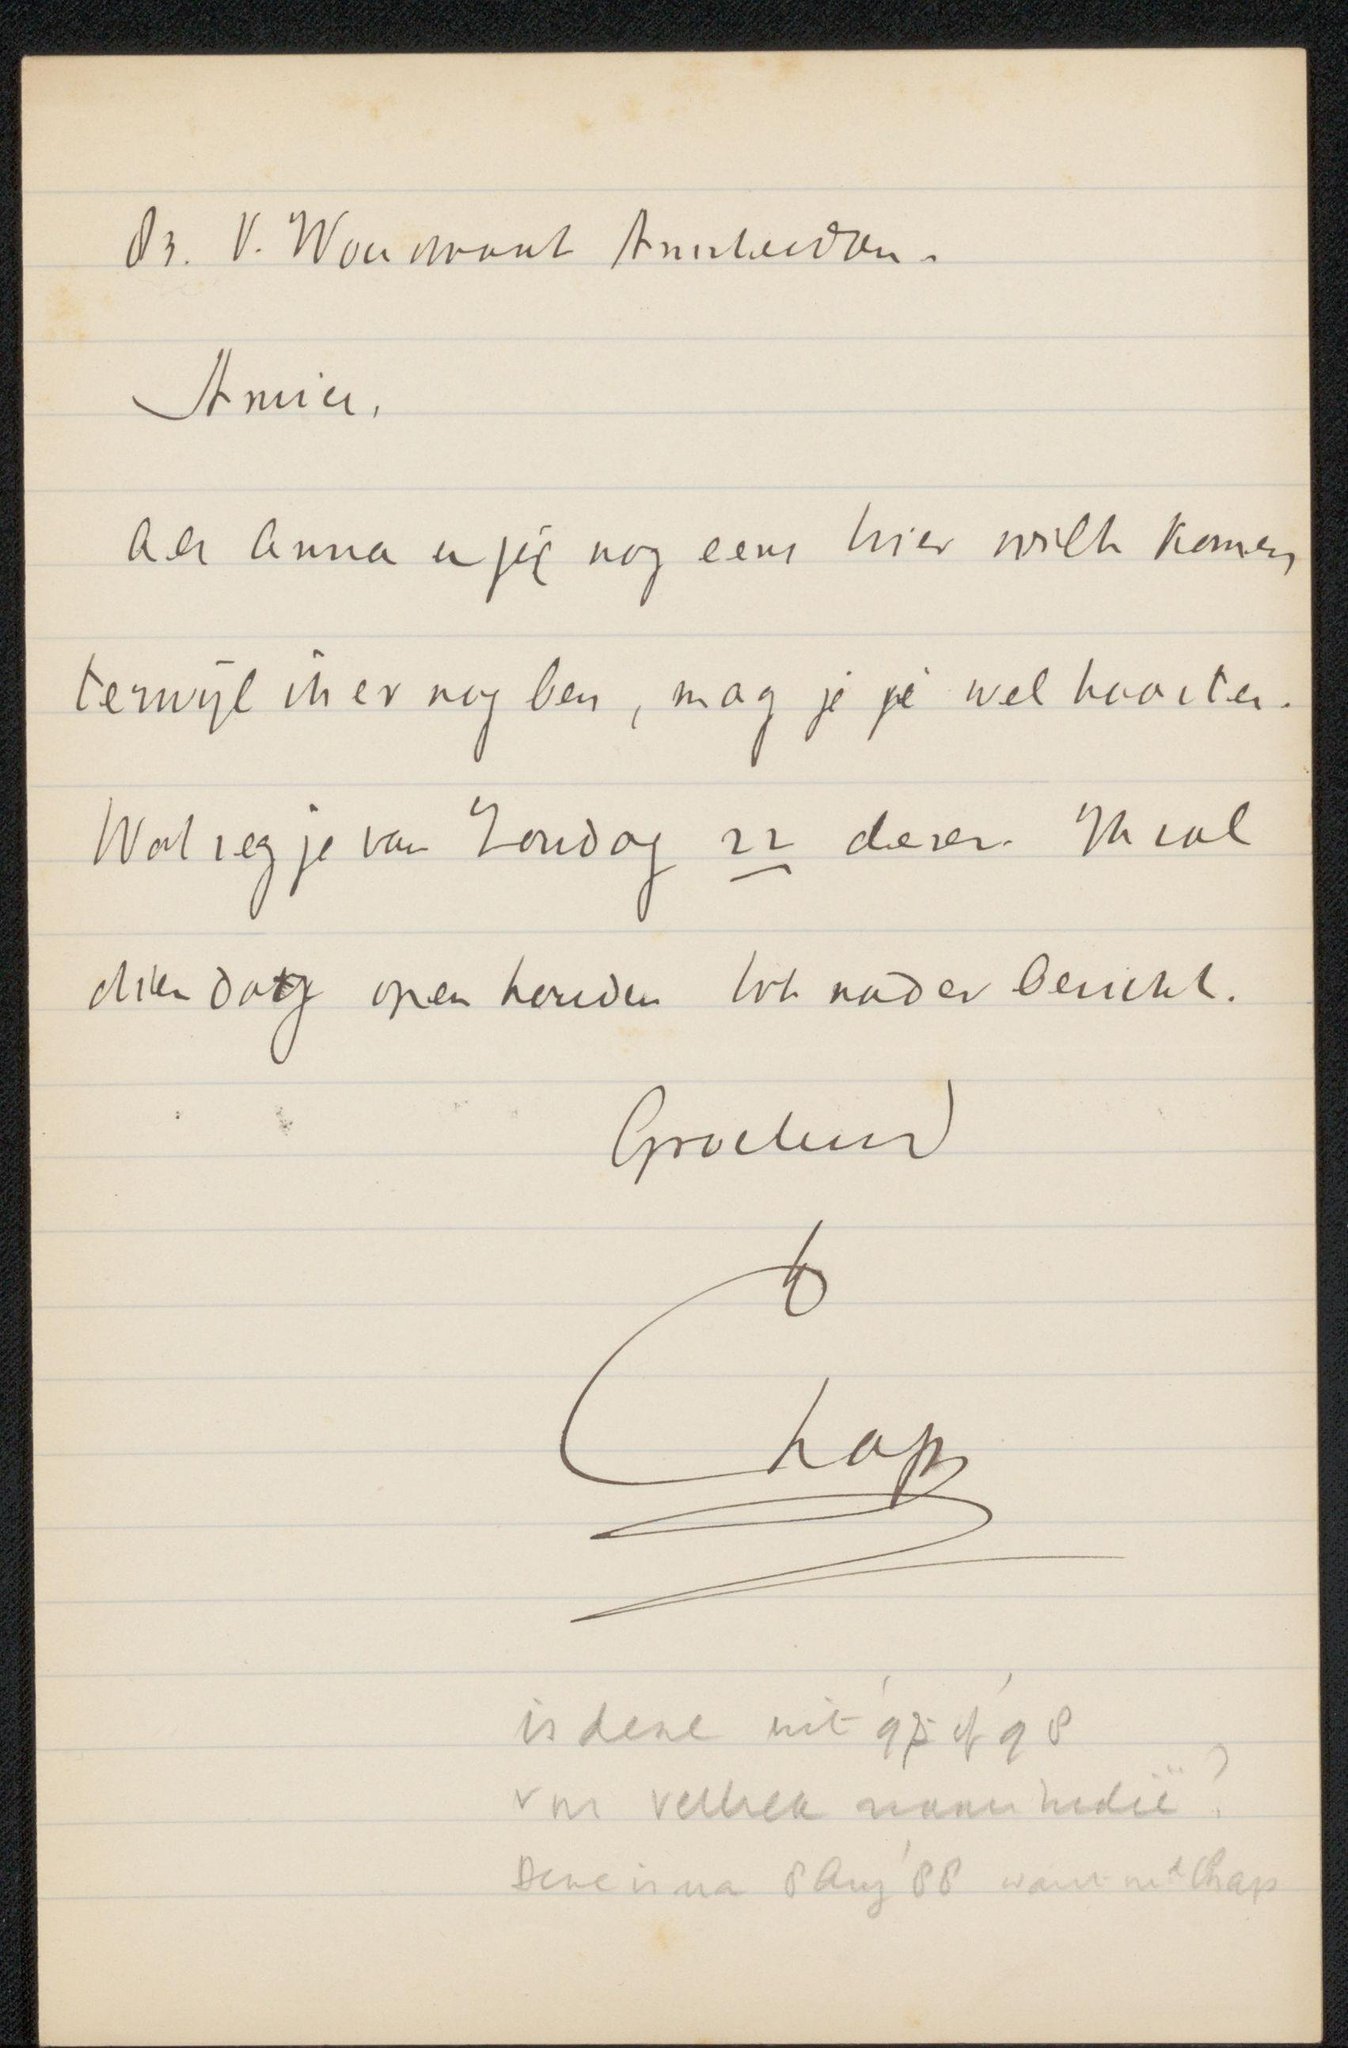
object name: letter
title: Brief aan Jan Veth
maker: chap van deventer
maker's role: kunstcriticus, scheikundige, schrijver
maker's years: 1860-1931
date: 1874-1925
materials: ink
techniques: pen, writing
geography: amsterdam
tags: painter, draughtsman, designer, jan veth, artist, anna dorothea dirks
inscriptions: collector's mark: ‘RPK’